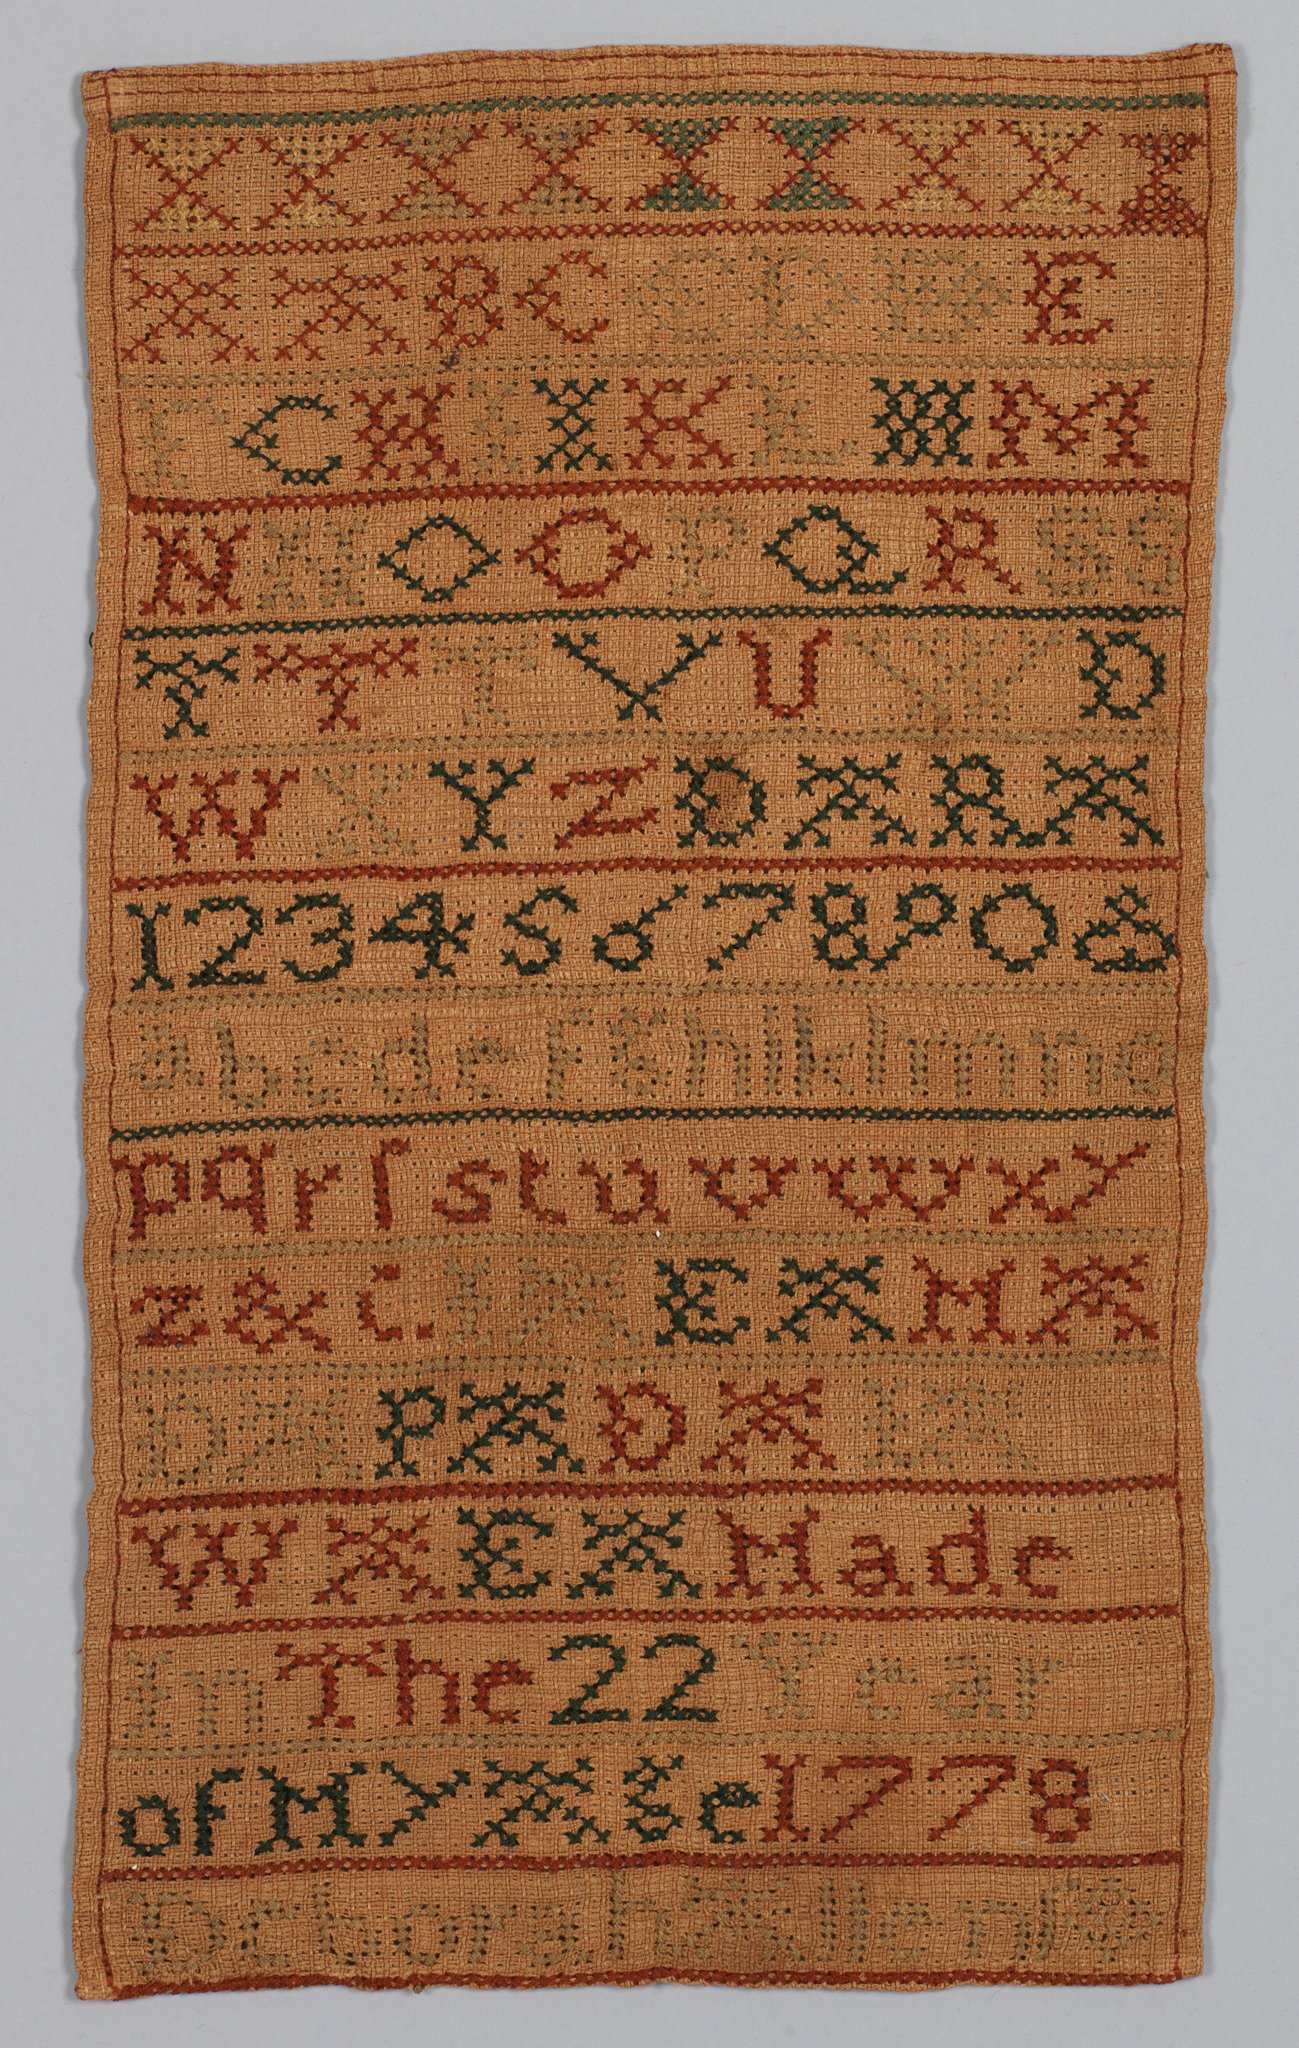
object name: sampler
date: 1778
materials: canvas, linen, silk